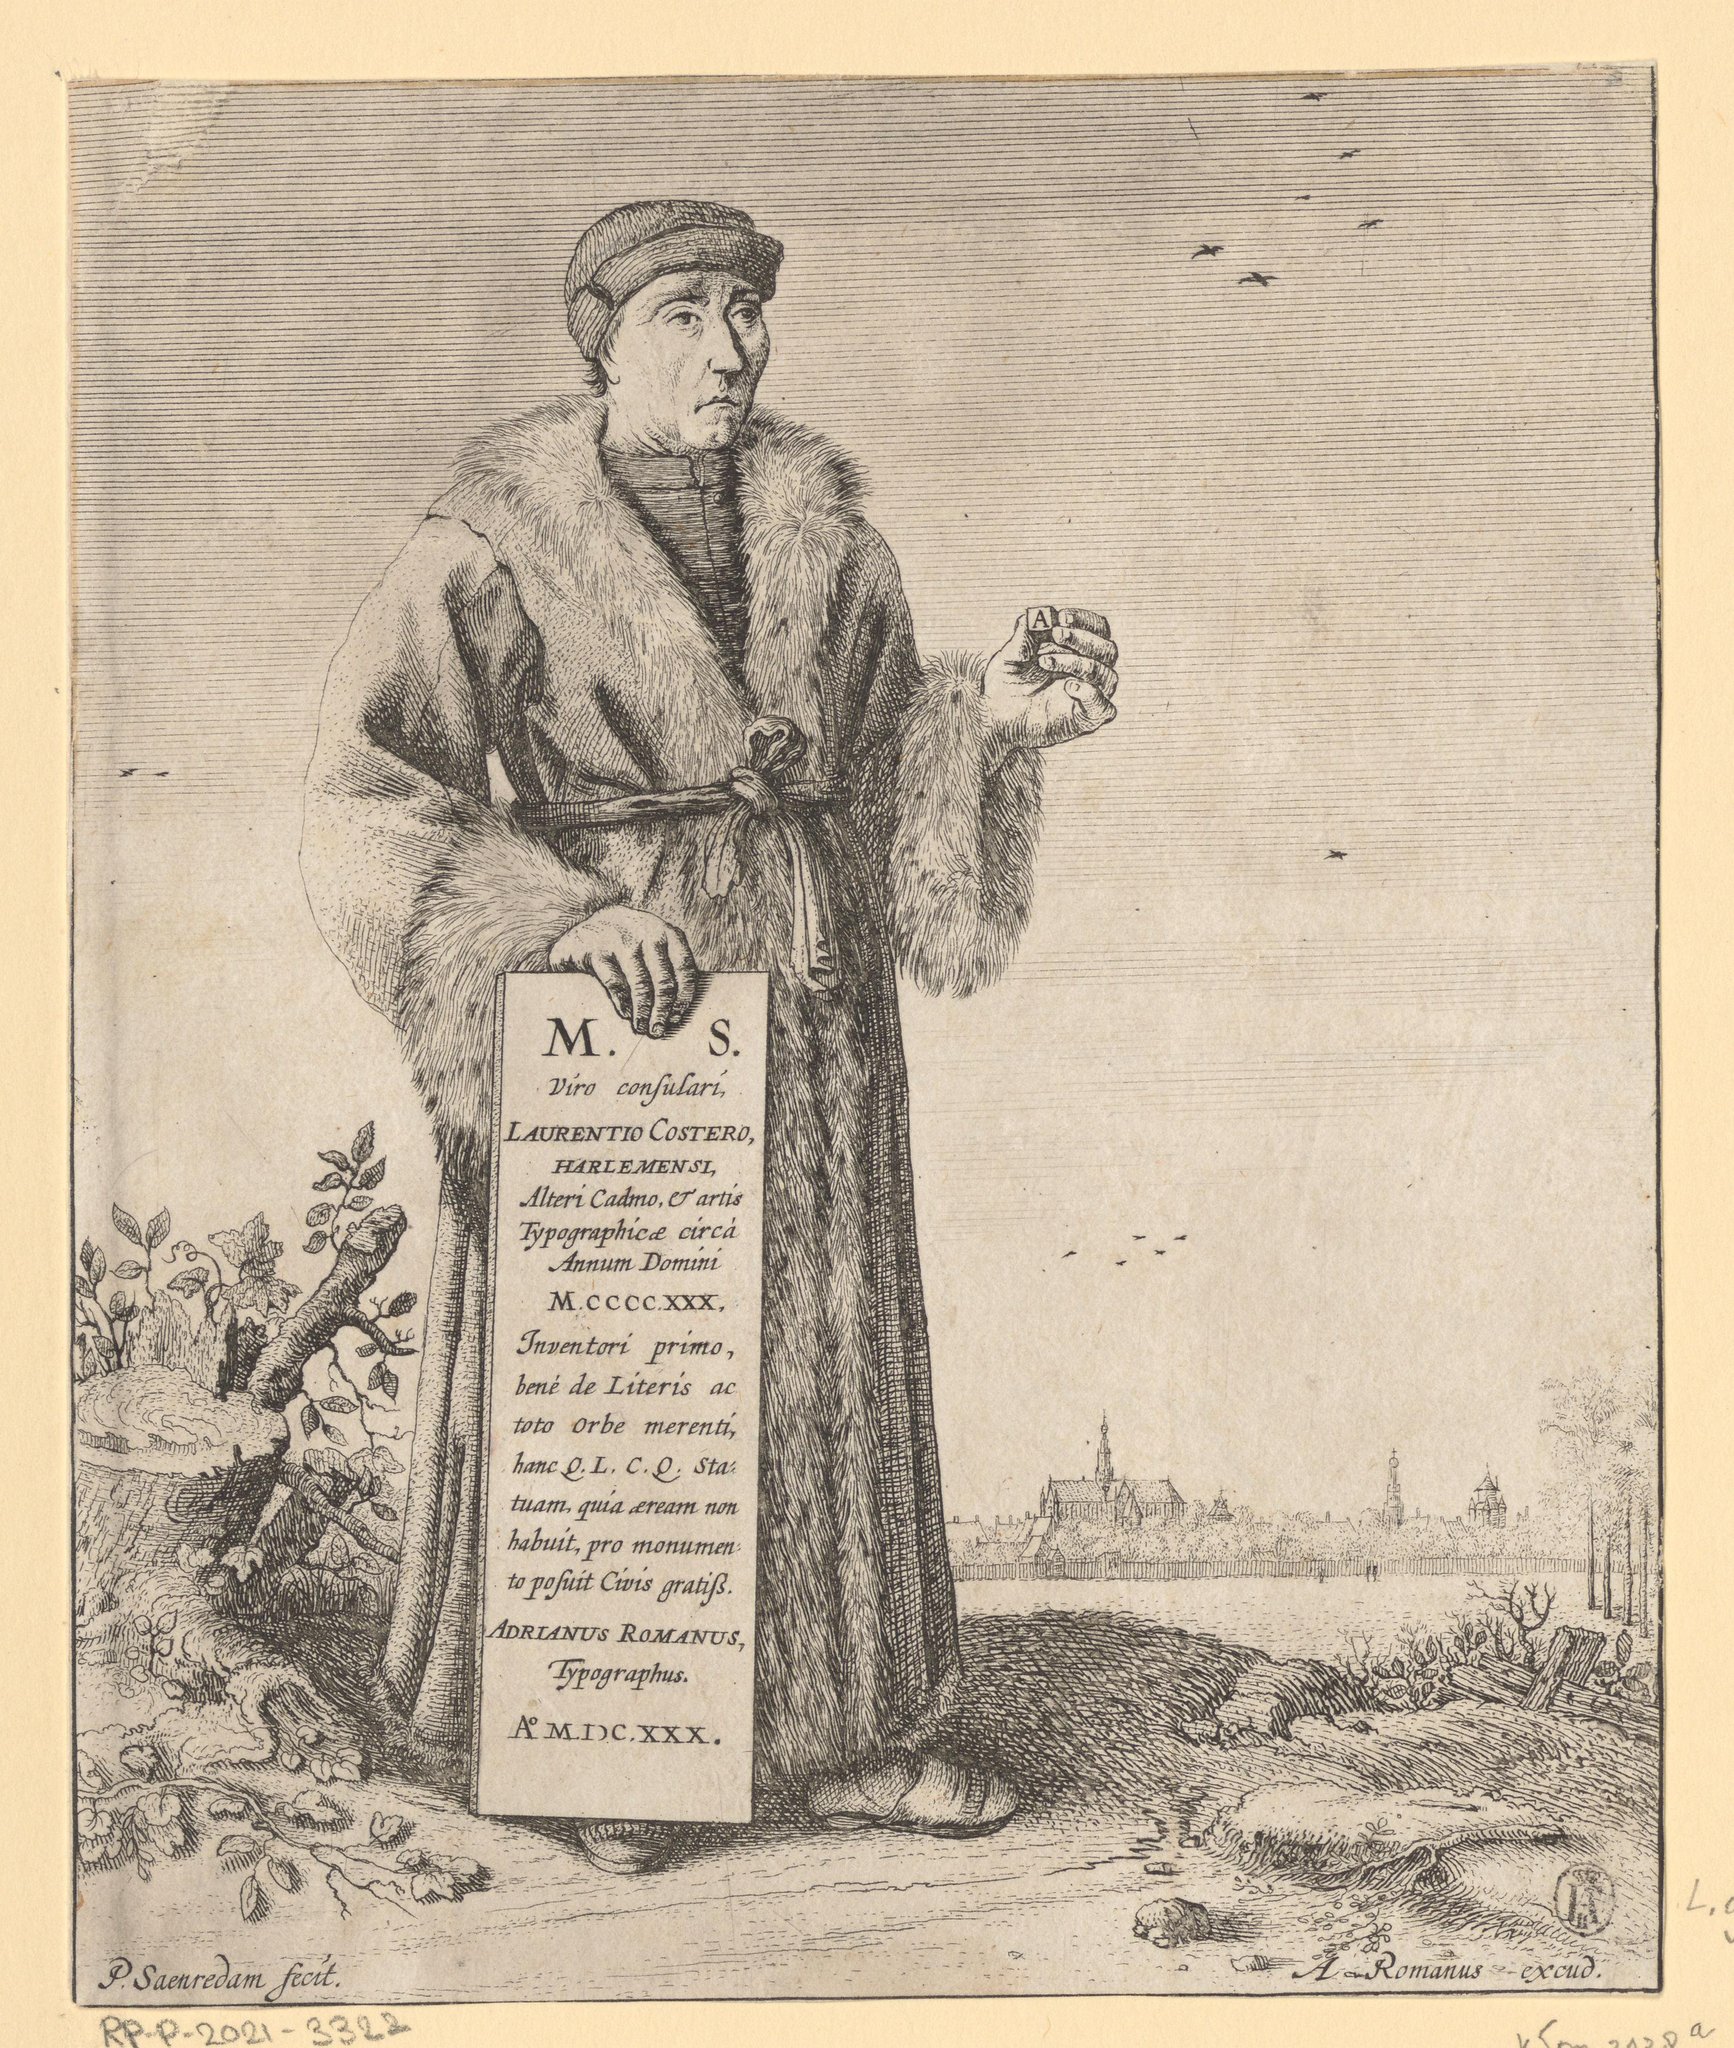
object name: print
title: Portret van Laurens Janszoon Coster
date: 1630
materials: paper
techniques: engraving, etching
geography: haarlem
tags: haarlem, standing figure, historical persons, tools, implements of printer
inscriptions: collector's mark: Lugt 971, collector's mark: Lugt 2228